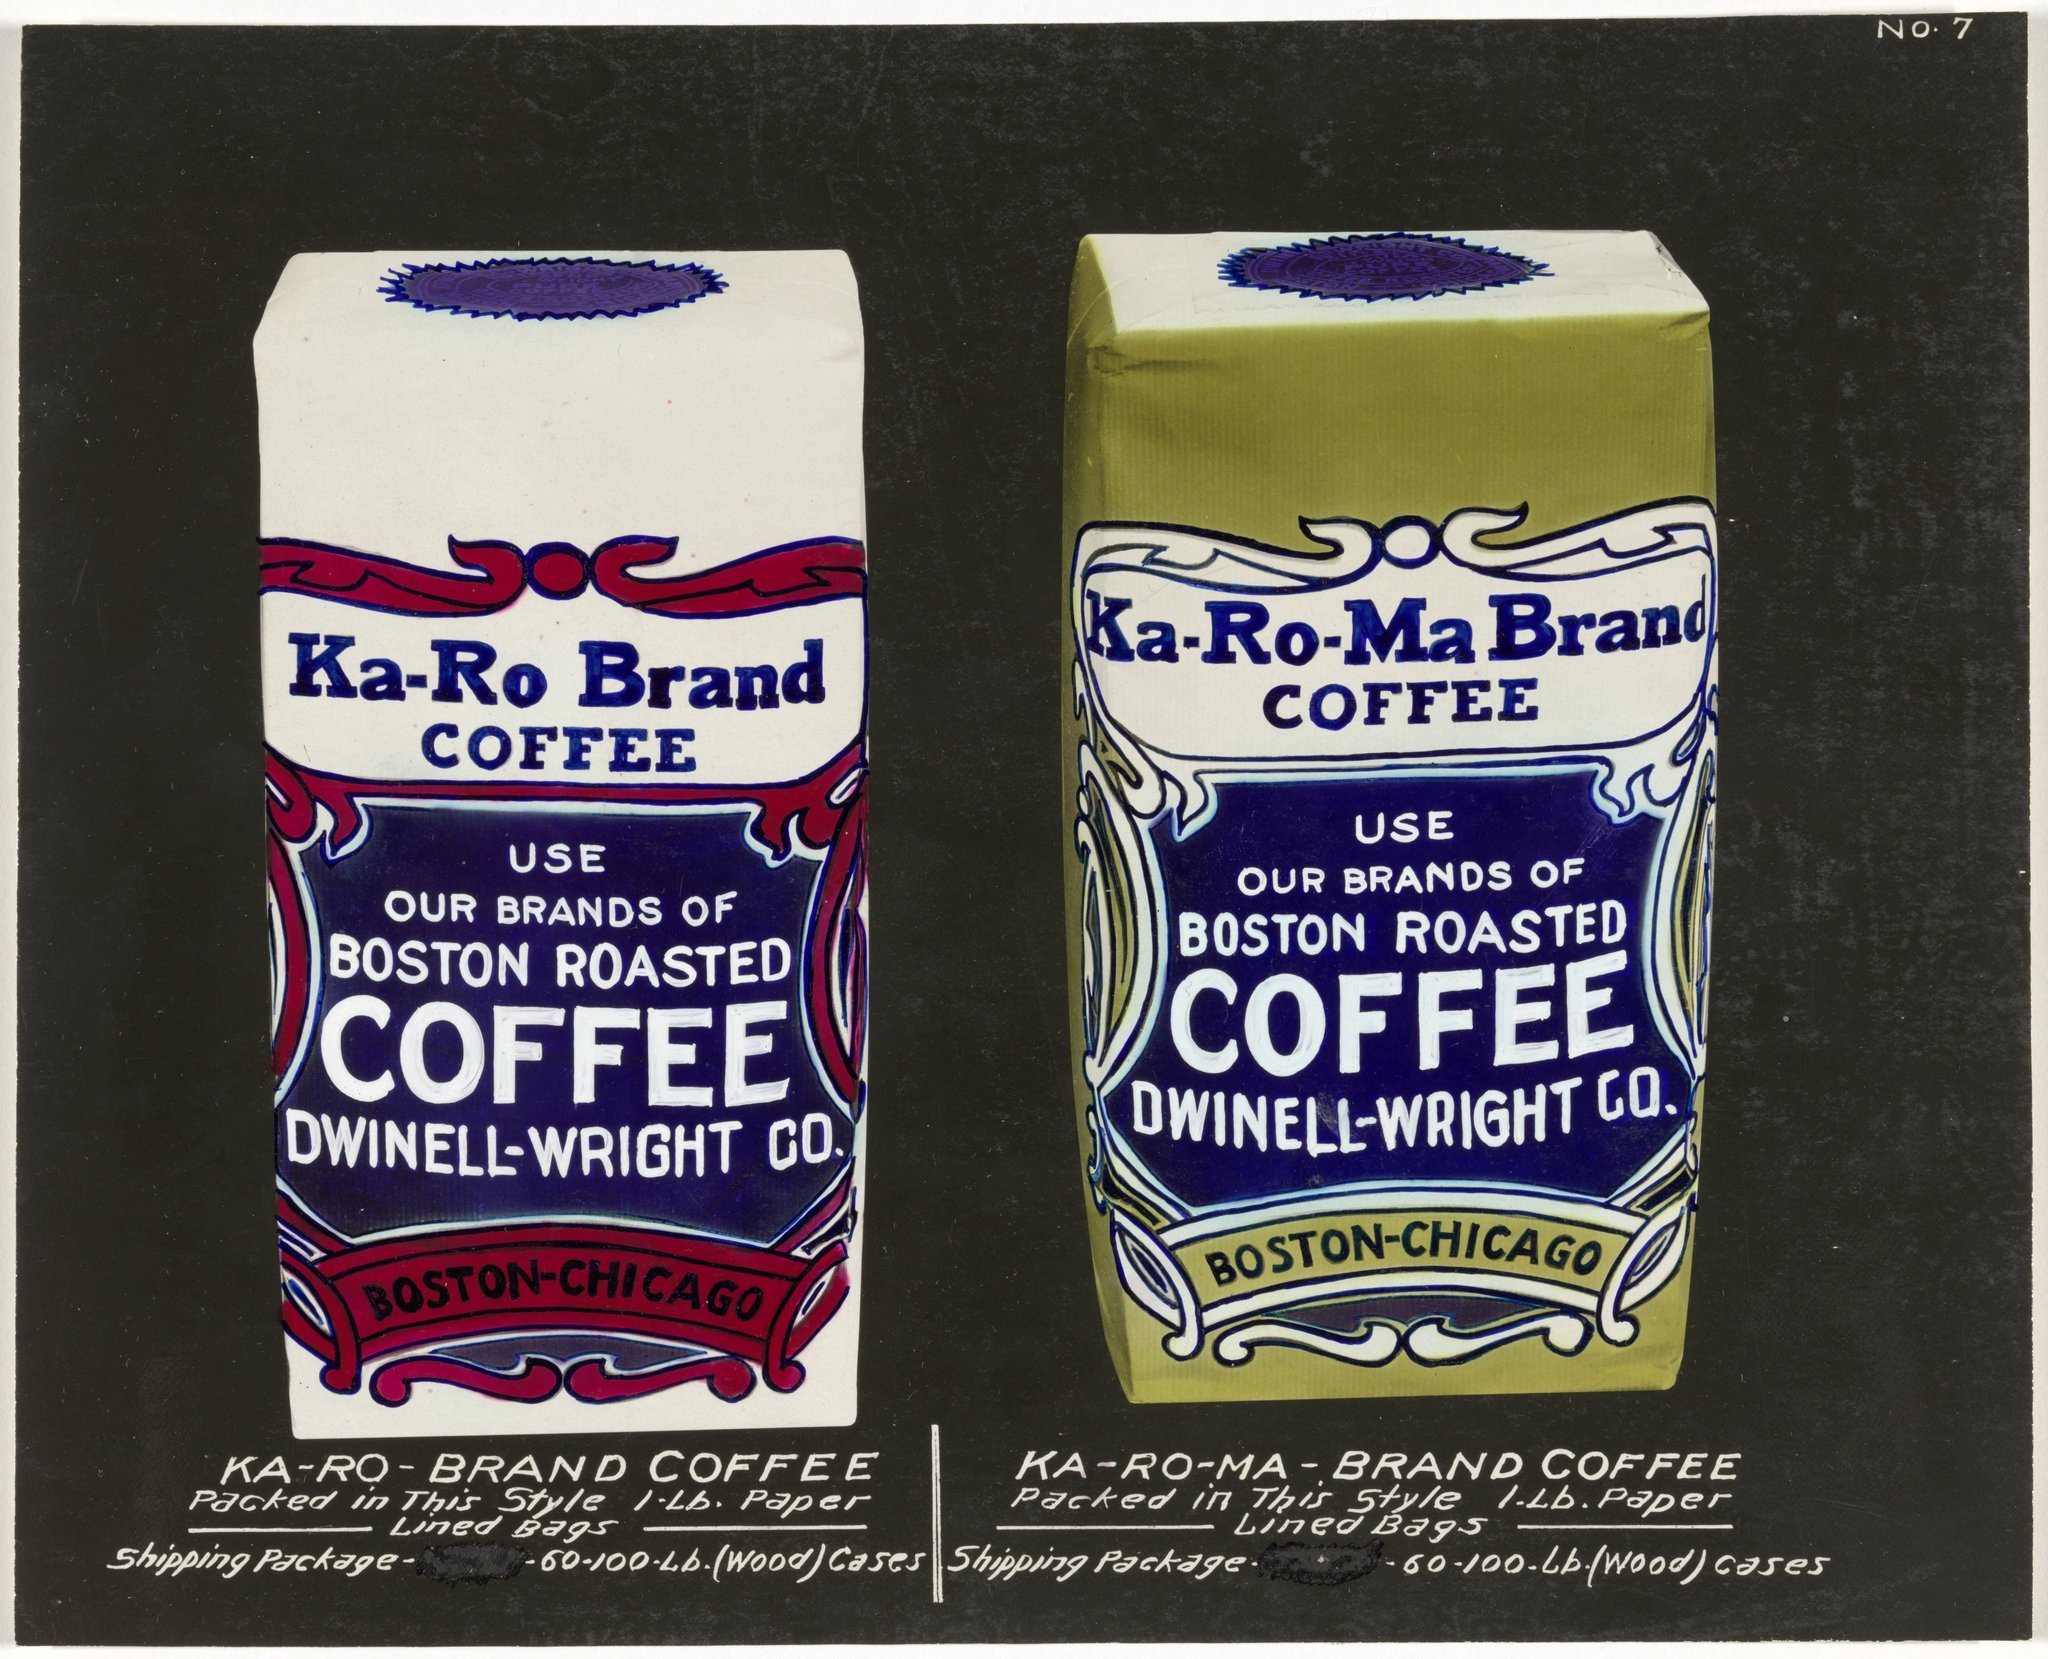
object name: photograph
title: Verpakkingen van 'Ka-Ro-Ma Brand' koffie, reclame voor Dwinell-Wright Company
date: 1911-1920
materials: paper, textile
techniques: gelatin silver print, hand coloring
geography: united states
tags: coffee, advertising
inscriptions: number: ‘No. 7’